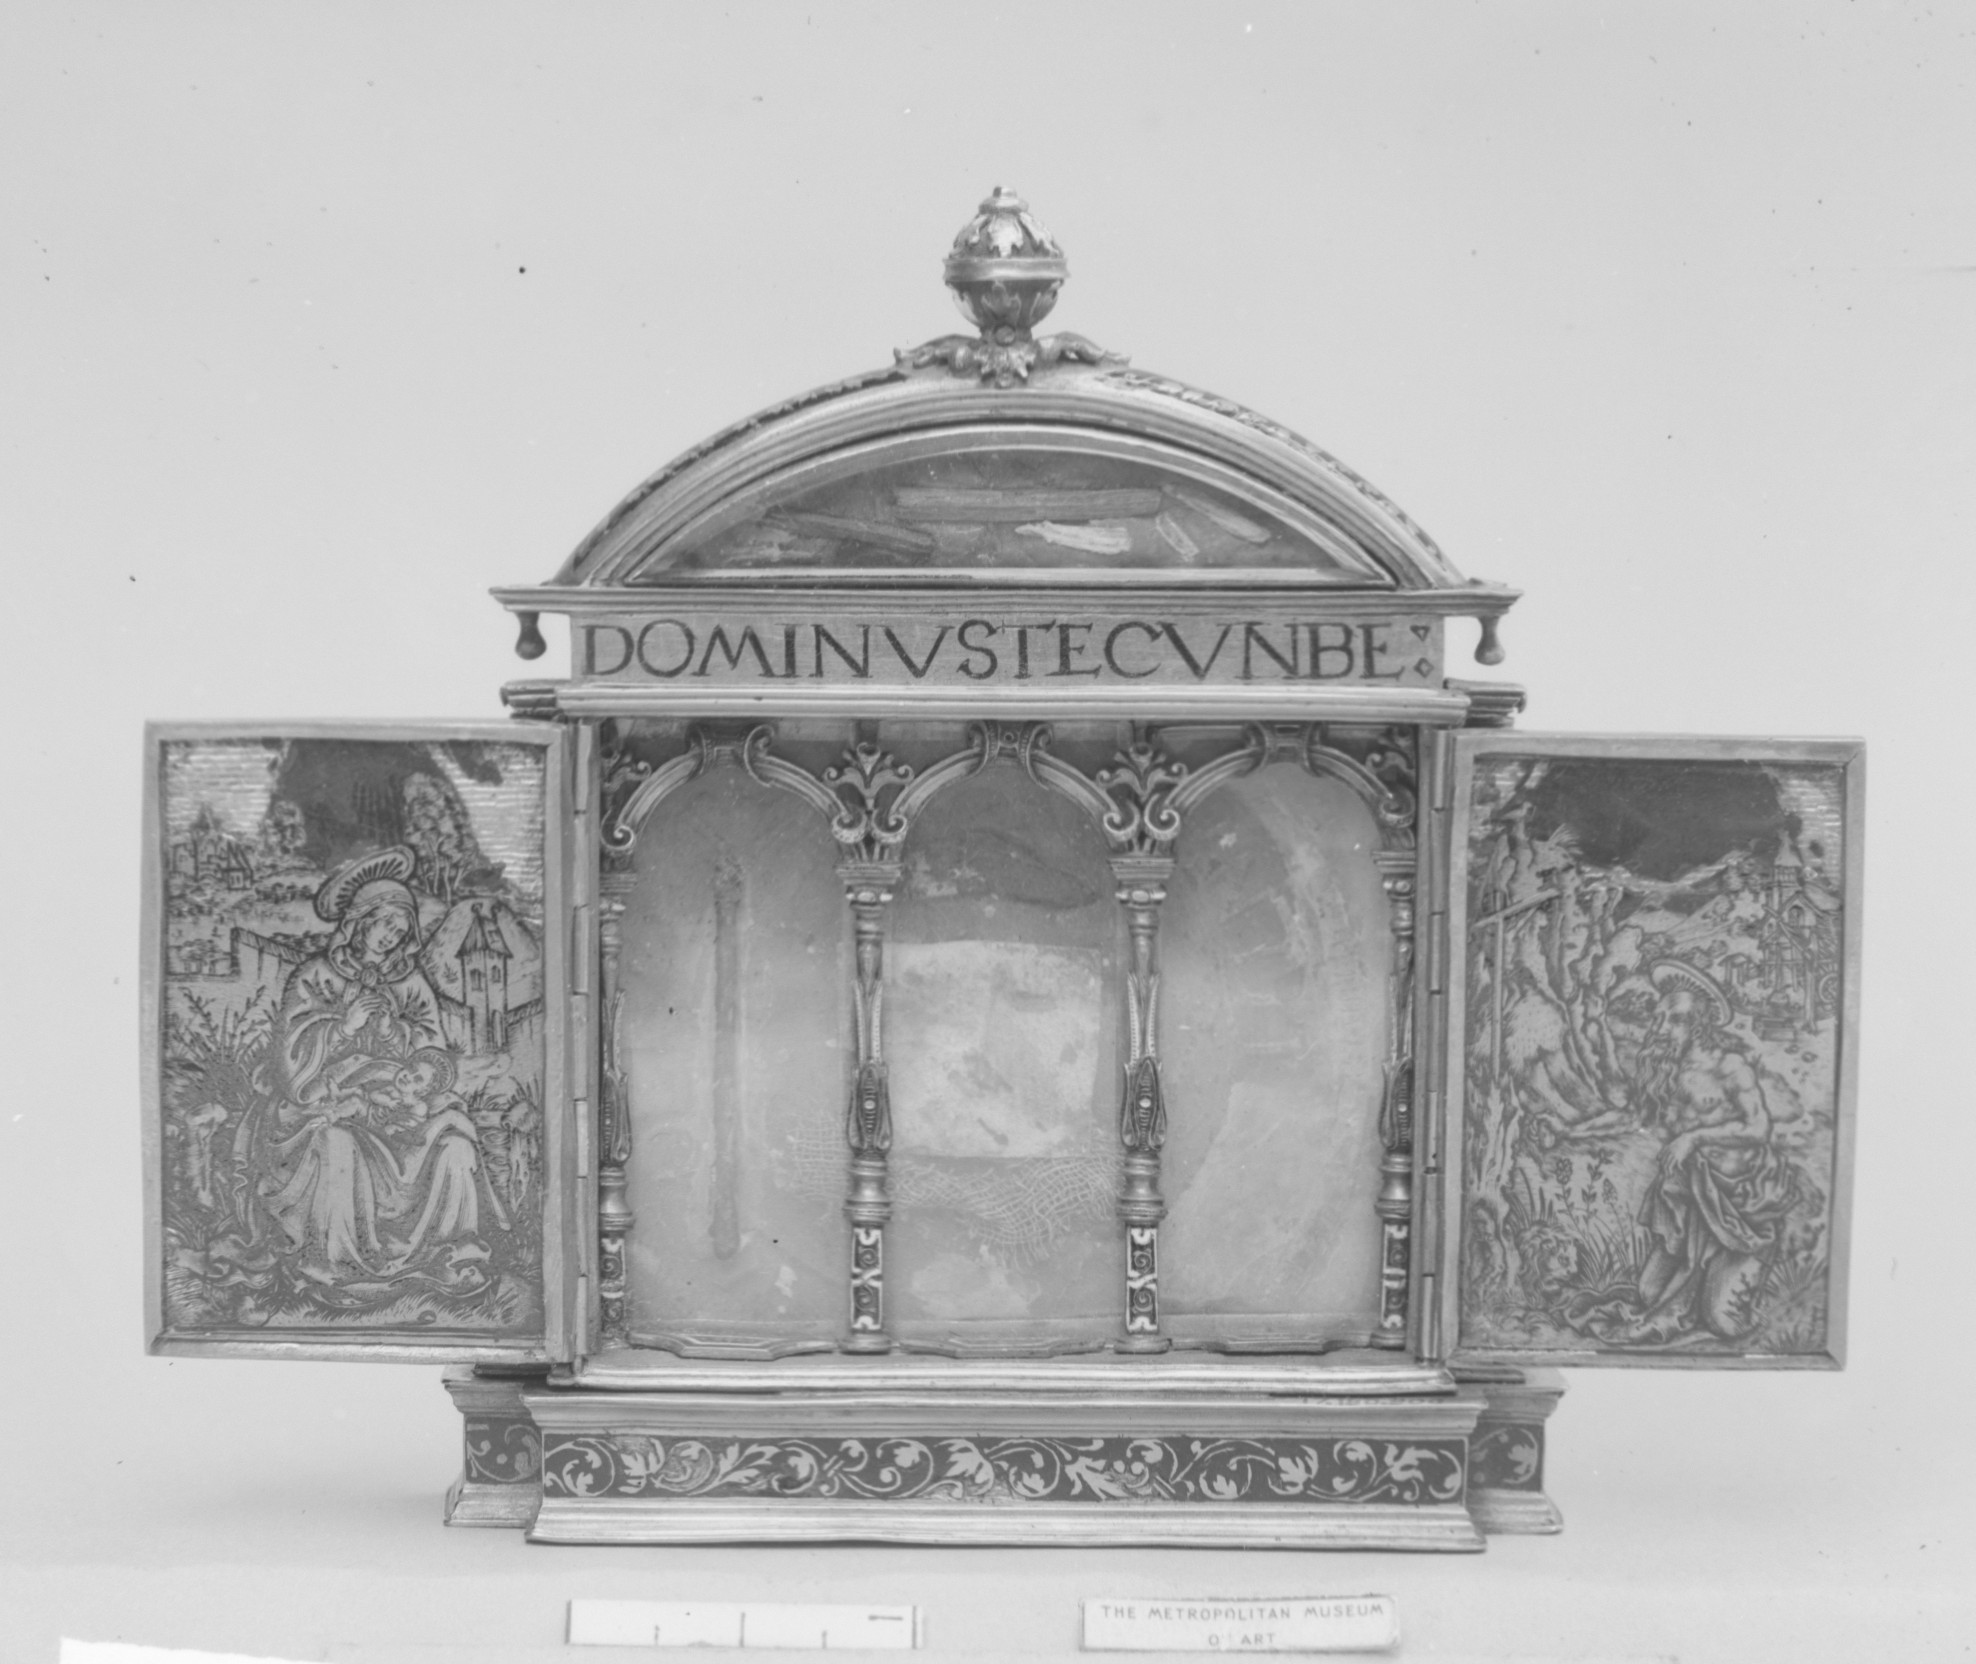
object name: reliquary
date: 1801-1900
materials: crystal, enamel, gold, niello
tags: men,women,jesus,reliquaries